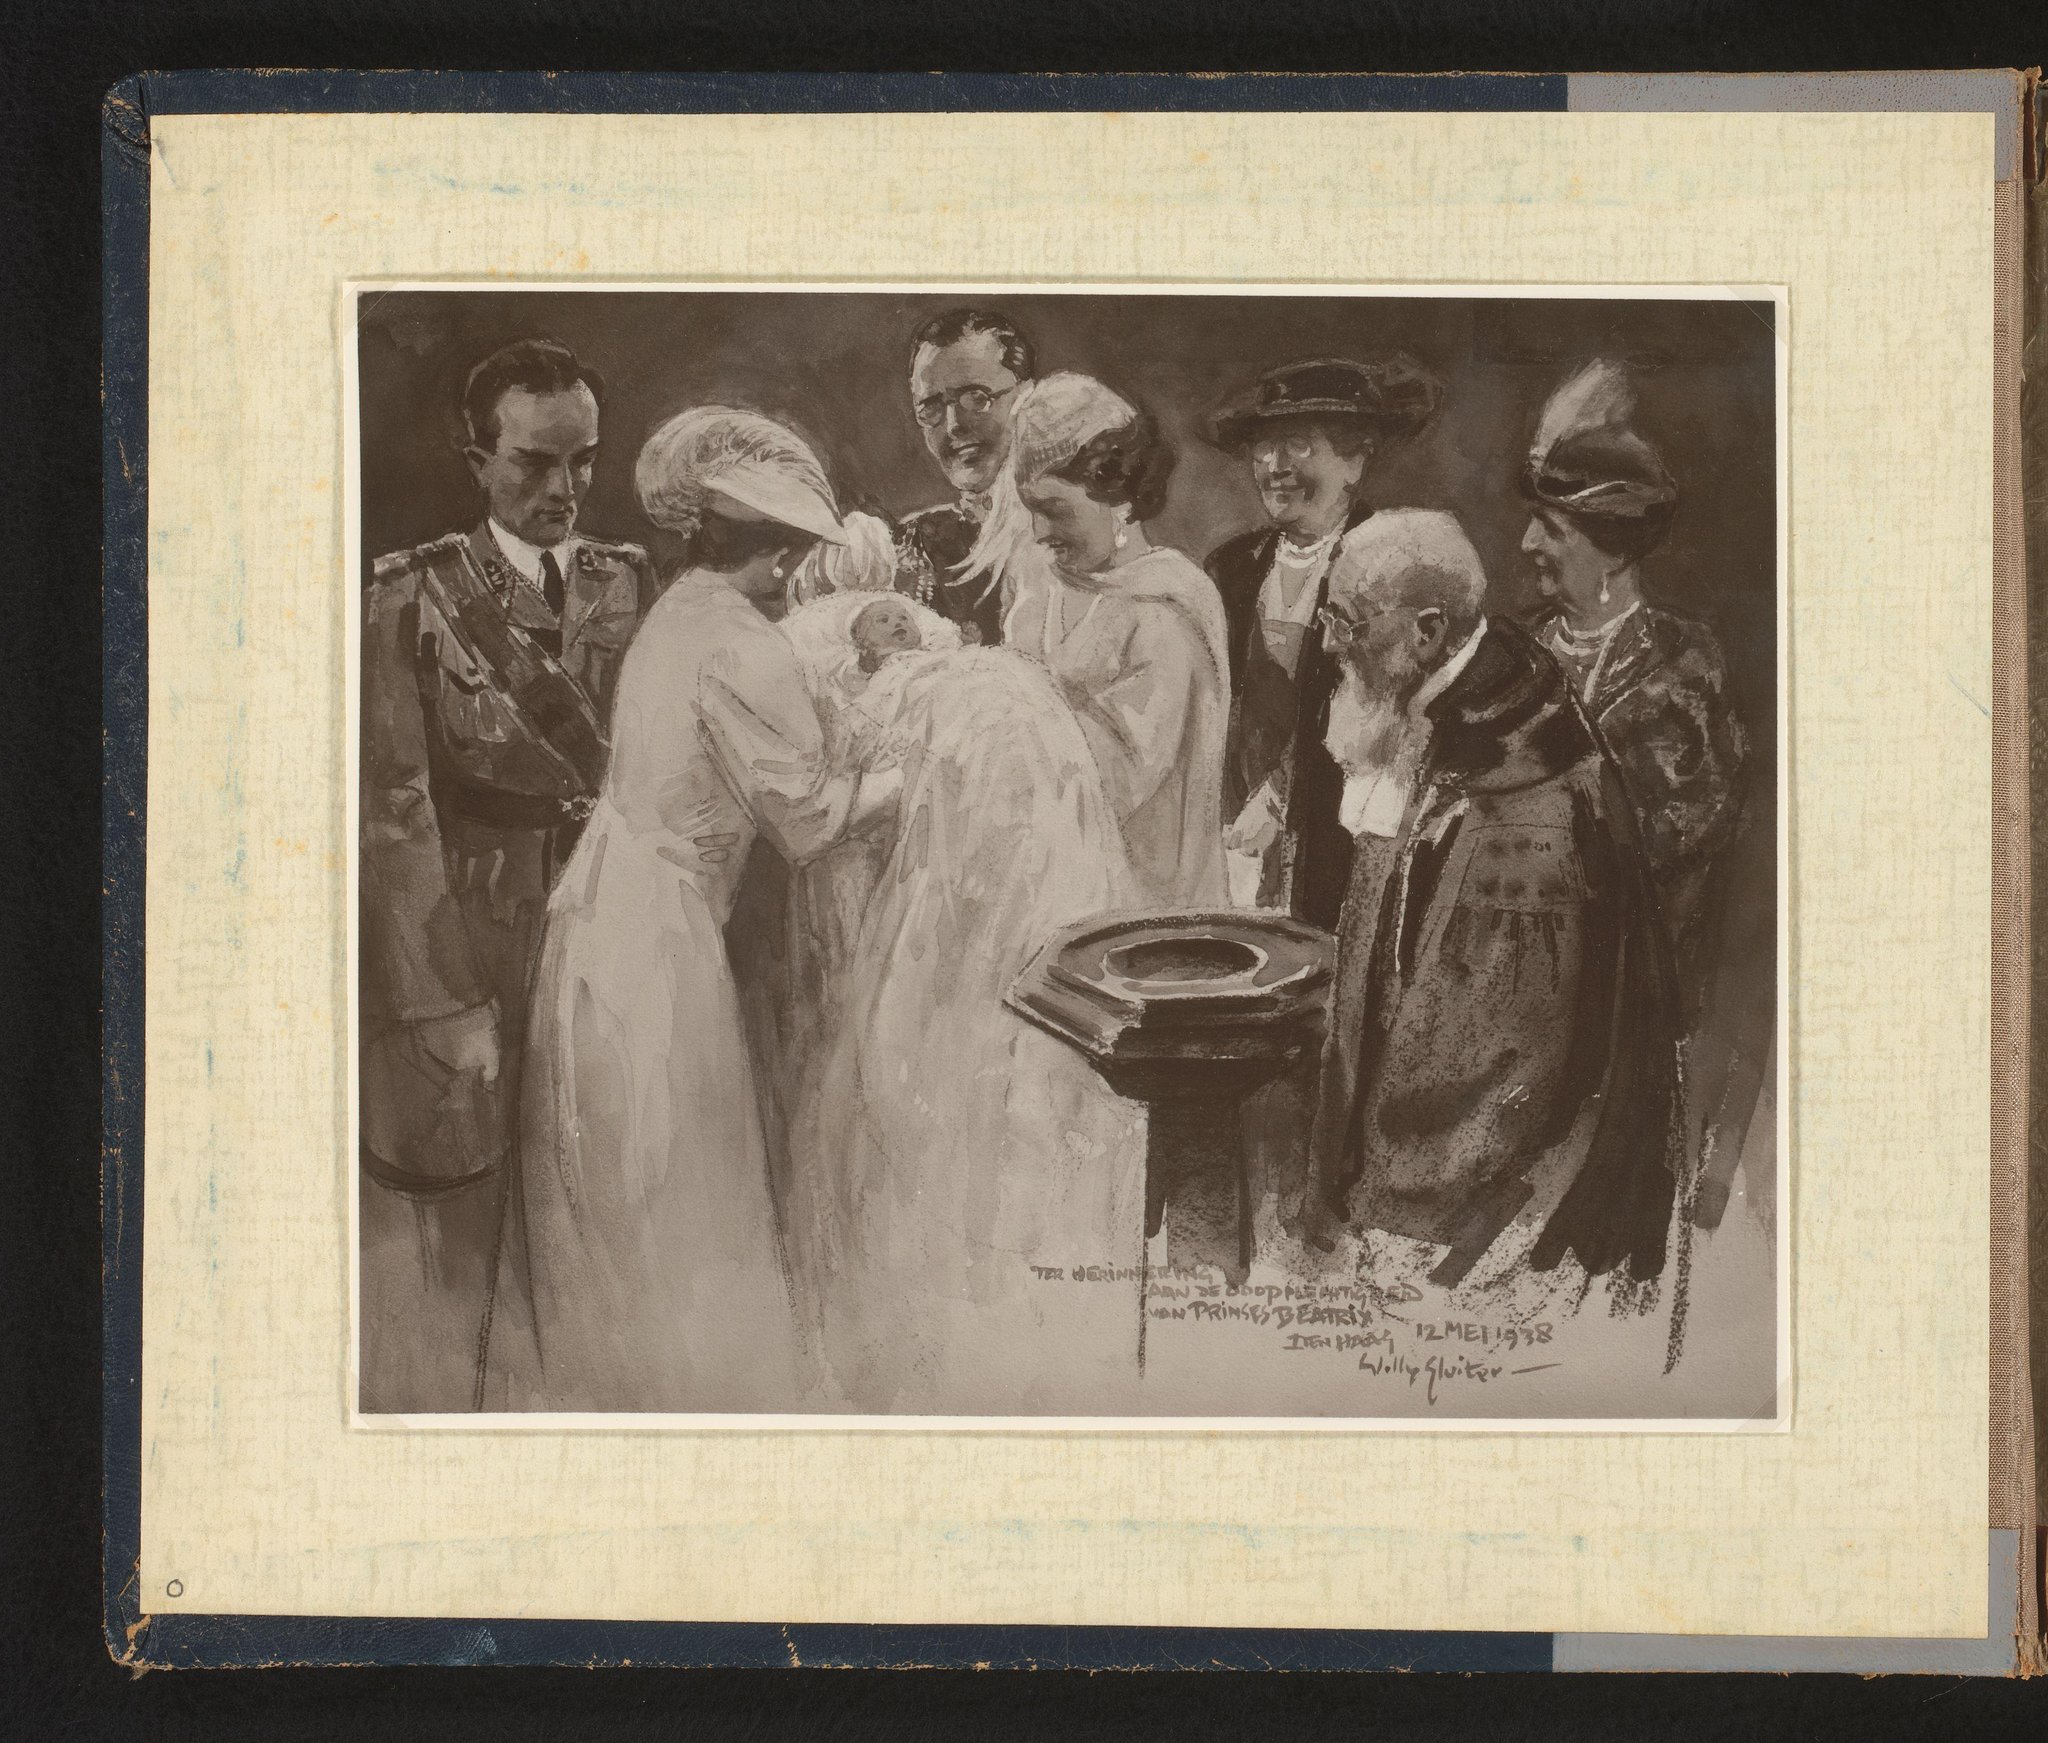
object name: photograph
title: Fotoreproductie van een tekening van de doop van prinses Beatrix, 12 mei 1938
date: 1938-1939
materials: cardboard, photographic support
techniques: gelatin silver print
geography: the hague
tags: utrecht, bernhard (prins der nederlanden), beatrix (koningin der nederlanden), juliana of the netherlands, baptism ~ protestant service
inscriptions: name: ‘Foto A. Frequin Wilhelminastr. 18 Den Haag - Holland’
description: Fotoreproductie van een tekening van de doop van prinses Beatrix, 12 mei 1938, ingeplakt op het schutblad voorin het album. Onderdeel van fotoalbum over het familieleven van de leden van het Koninklijk Huis tussen 1937-1945.